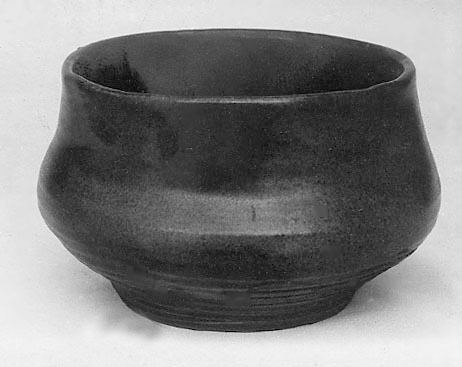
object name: teabowl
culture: japanese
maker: kenzan iii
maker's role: artist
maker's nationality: japanese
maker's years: 1767-1810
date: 1801-1833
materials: clay, glaze